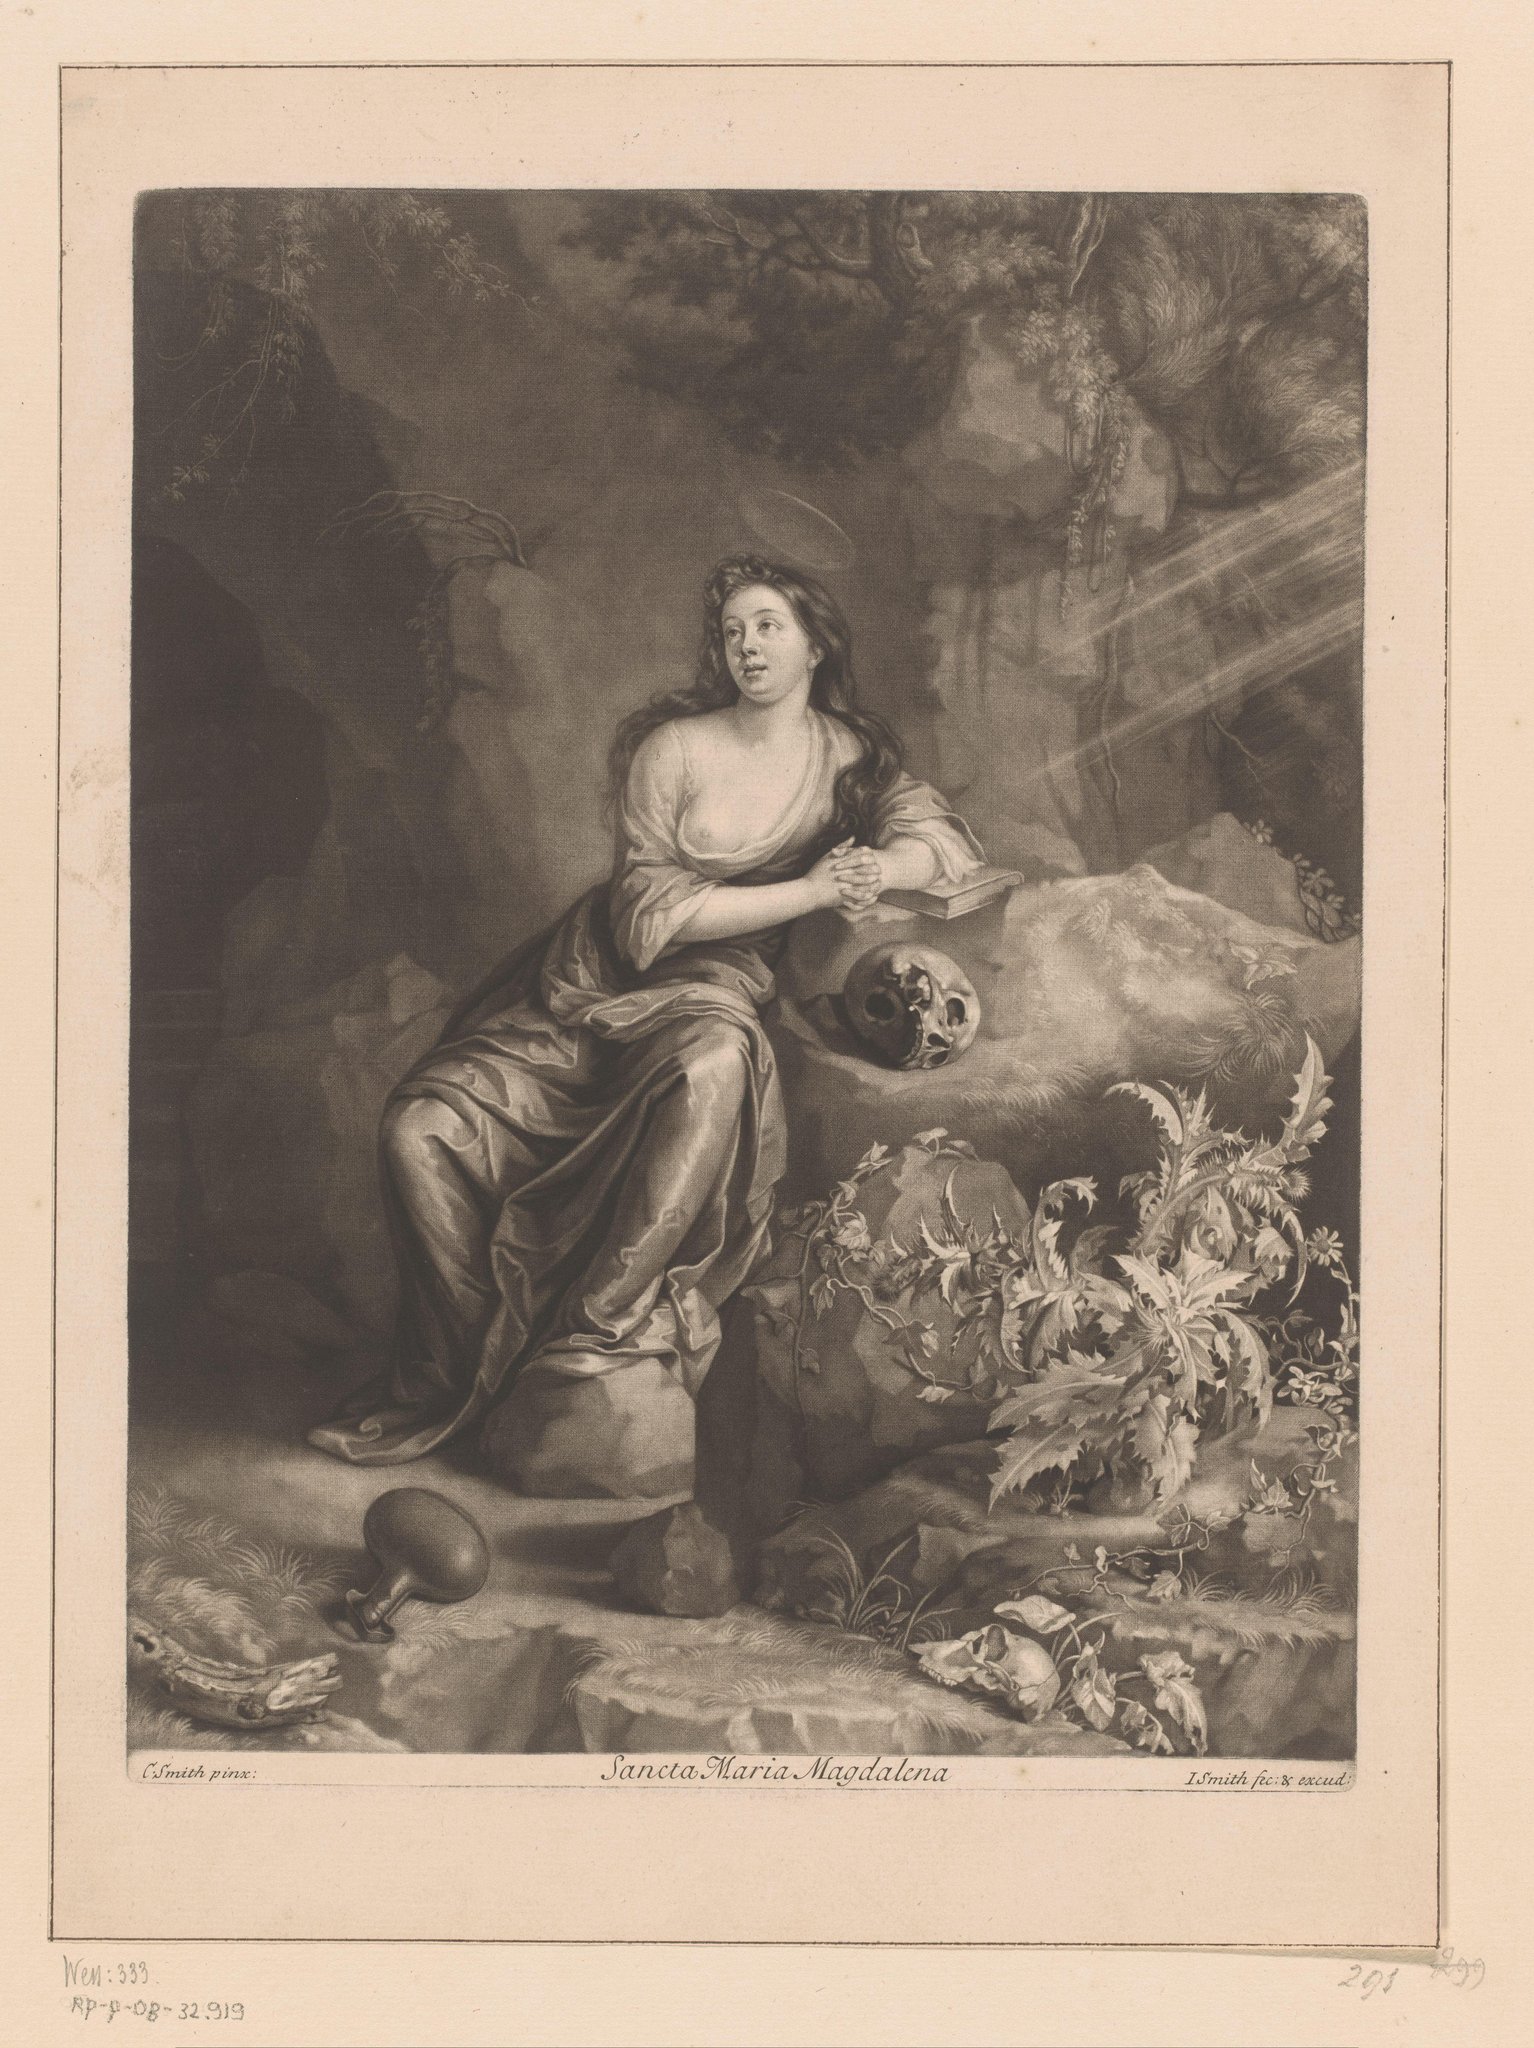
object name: print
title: Sancta Maria Magdalena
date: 1662-1742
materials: paper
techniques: mezzotint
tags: the penitent harlot mary magdalene; possible attributes: book (or scroll), crown, crown of thorns, crucifix, jar of ointment, mirror, musical instrument, palm-branch, rosary, scourge, plants and herbs: thistle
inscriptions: collector's mark: Lugt 240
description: Maria Magdalena leunt tegen een rots aan naast een distel.